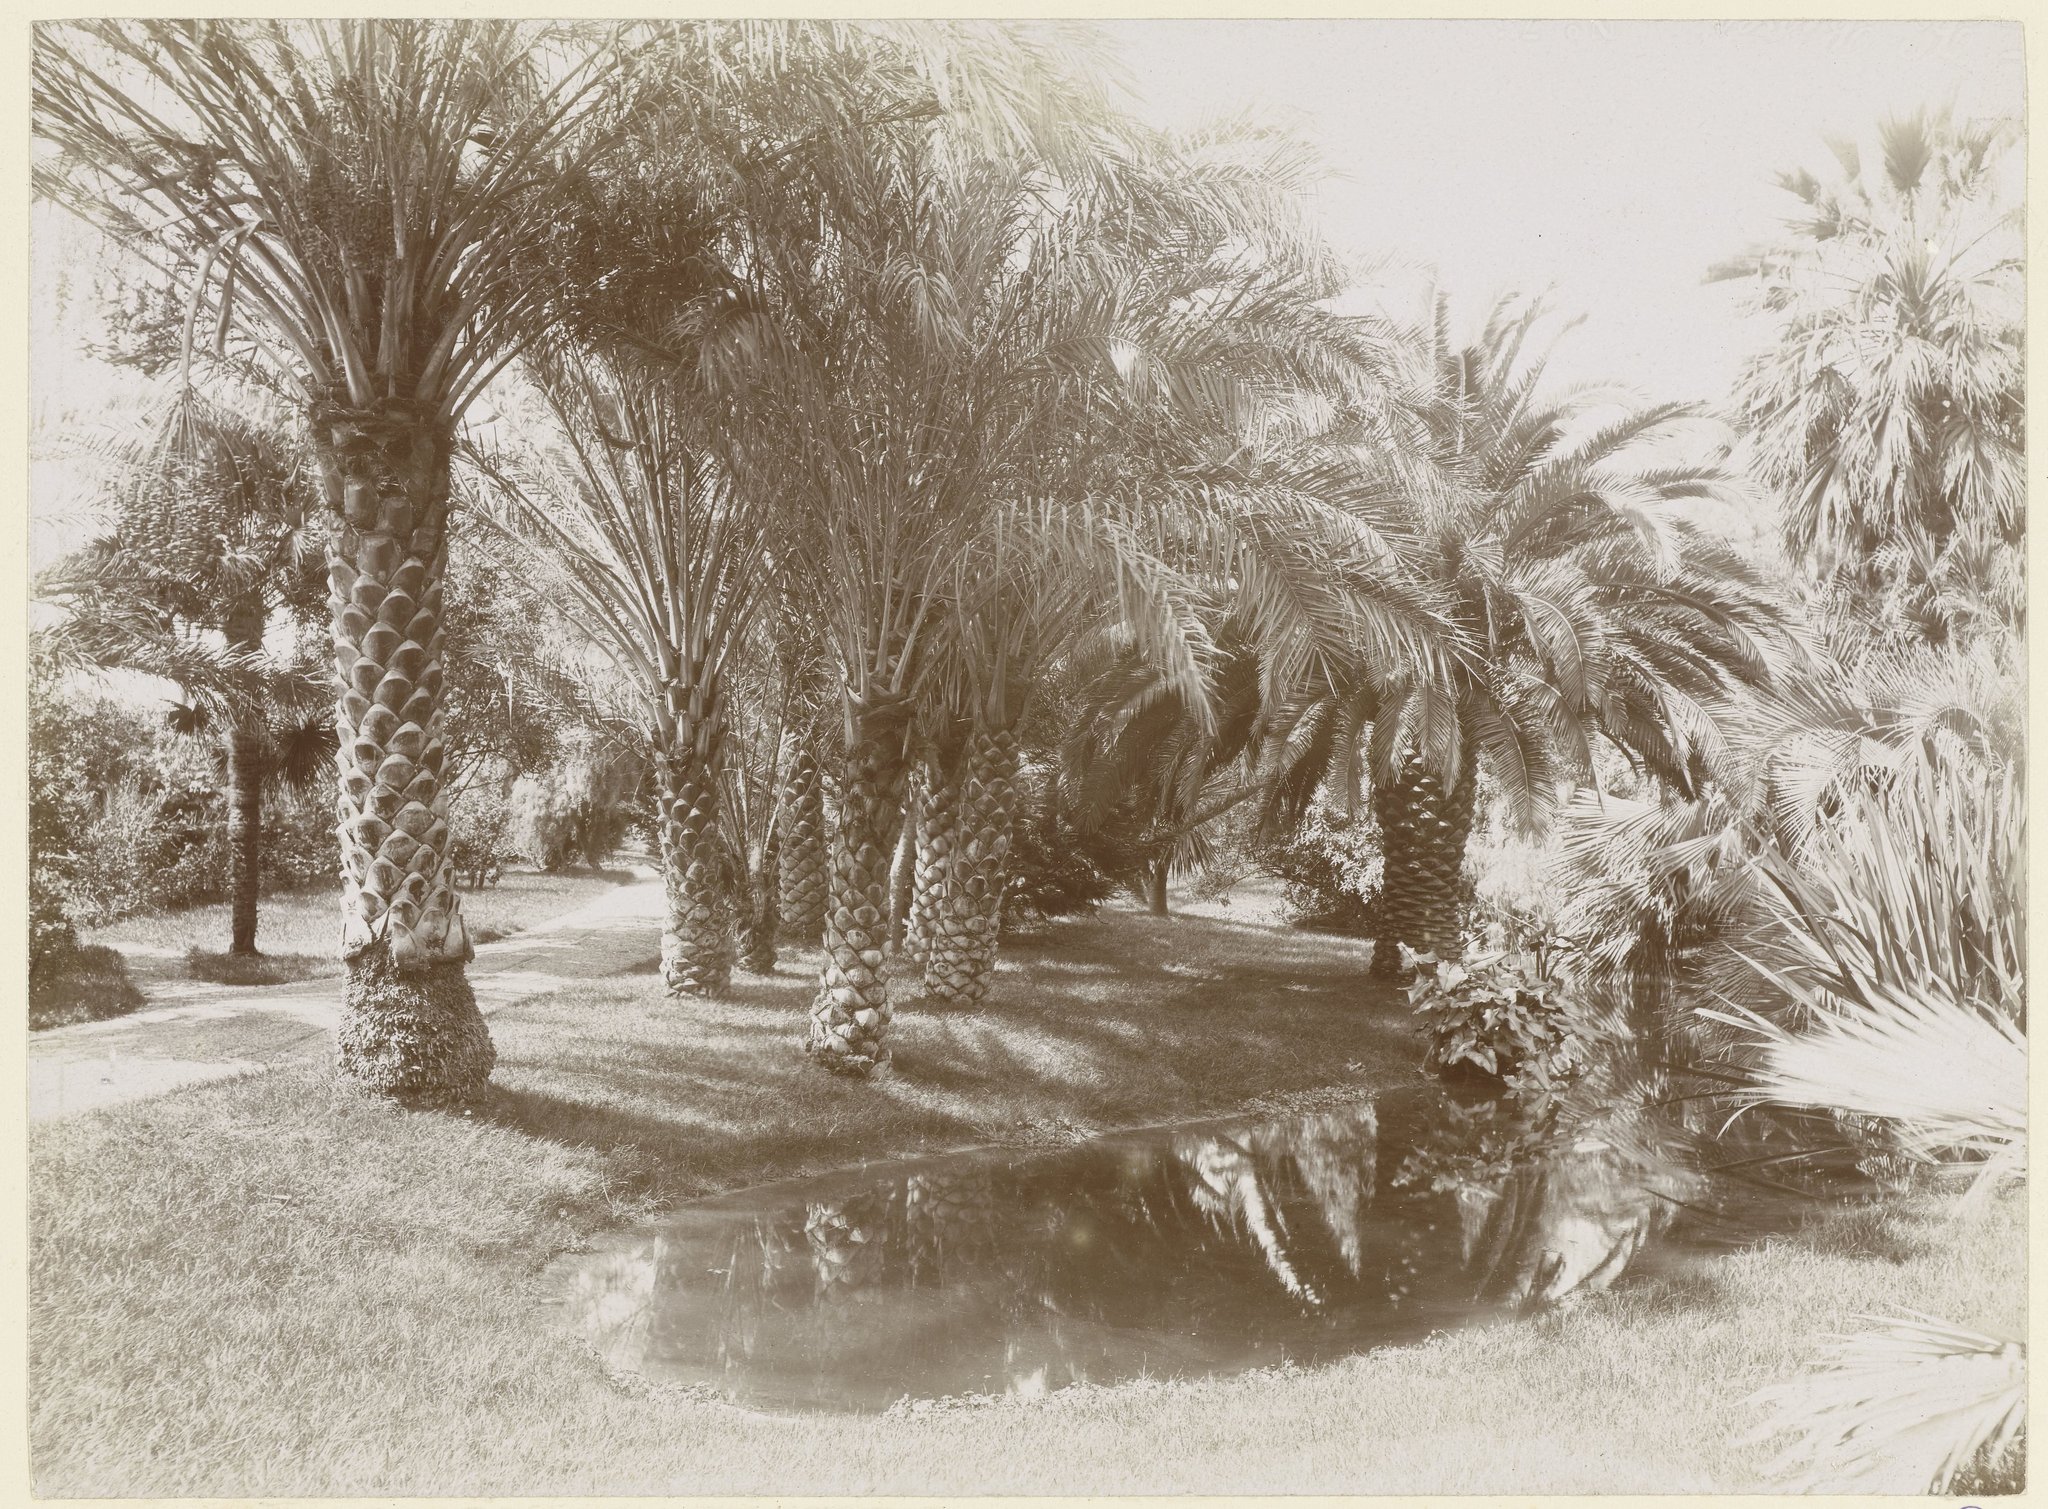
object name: photograph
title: De tuin, Villa Chauvassaignes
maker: henry pauw van wieldrecht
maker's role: fotograaf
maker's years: 1863-1912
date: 1886-1896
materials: cardboard, photographic support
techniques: albumen print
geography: france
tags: menton